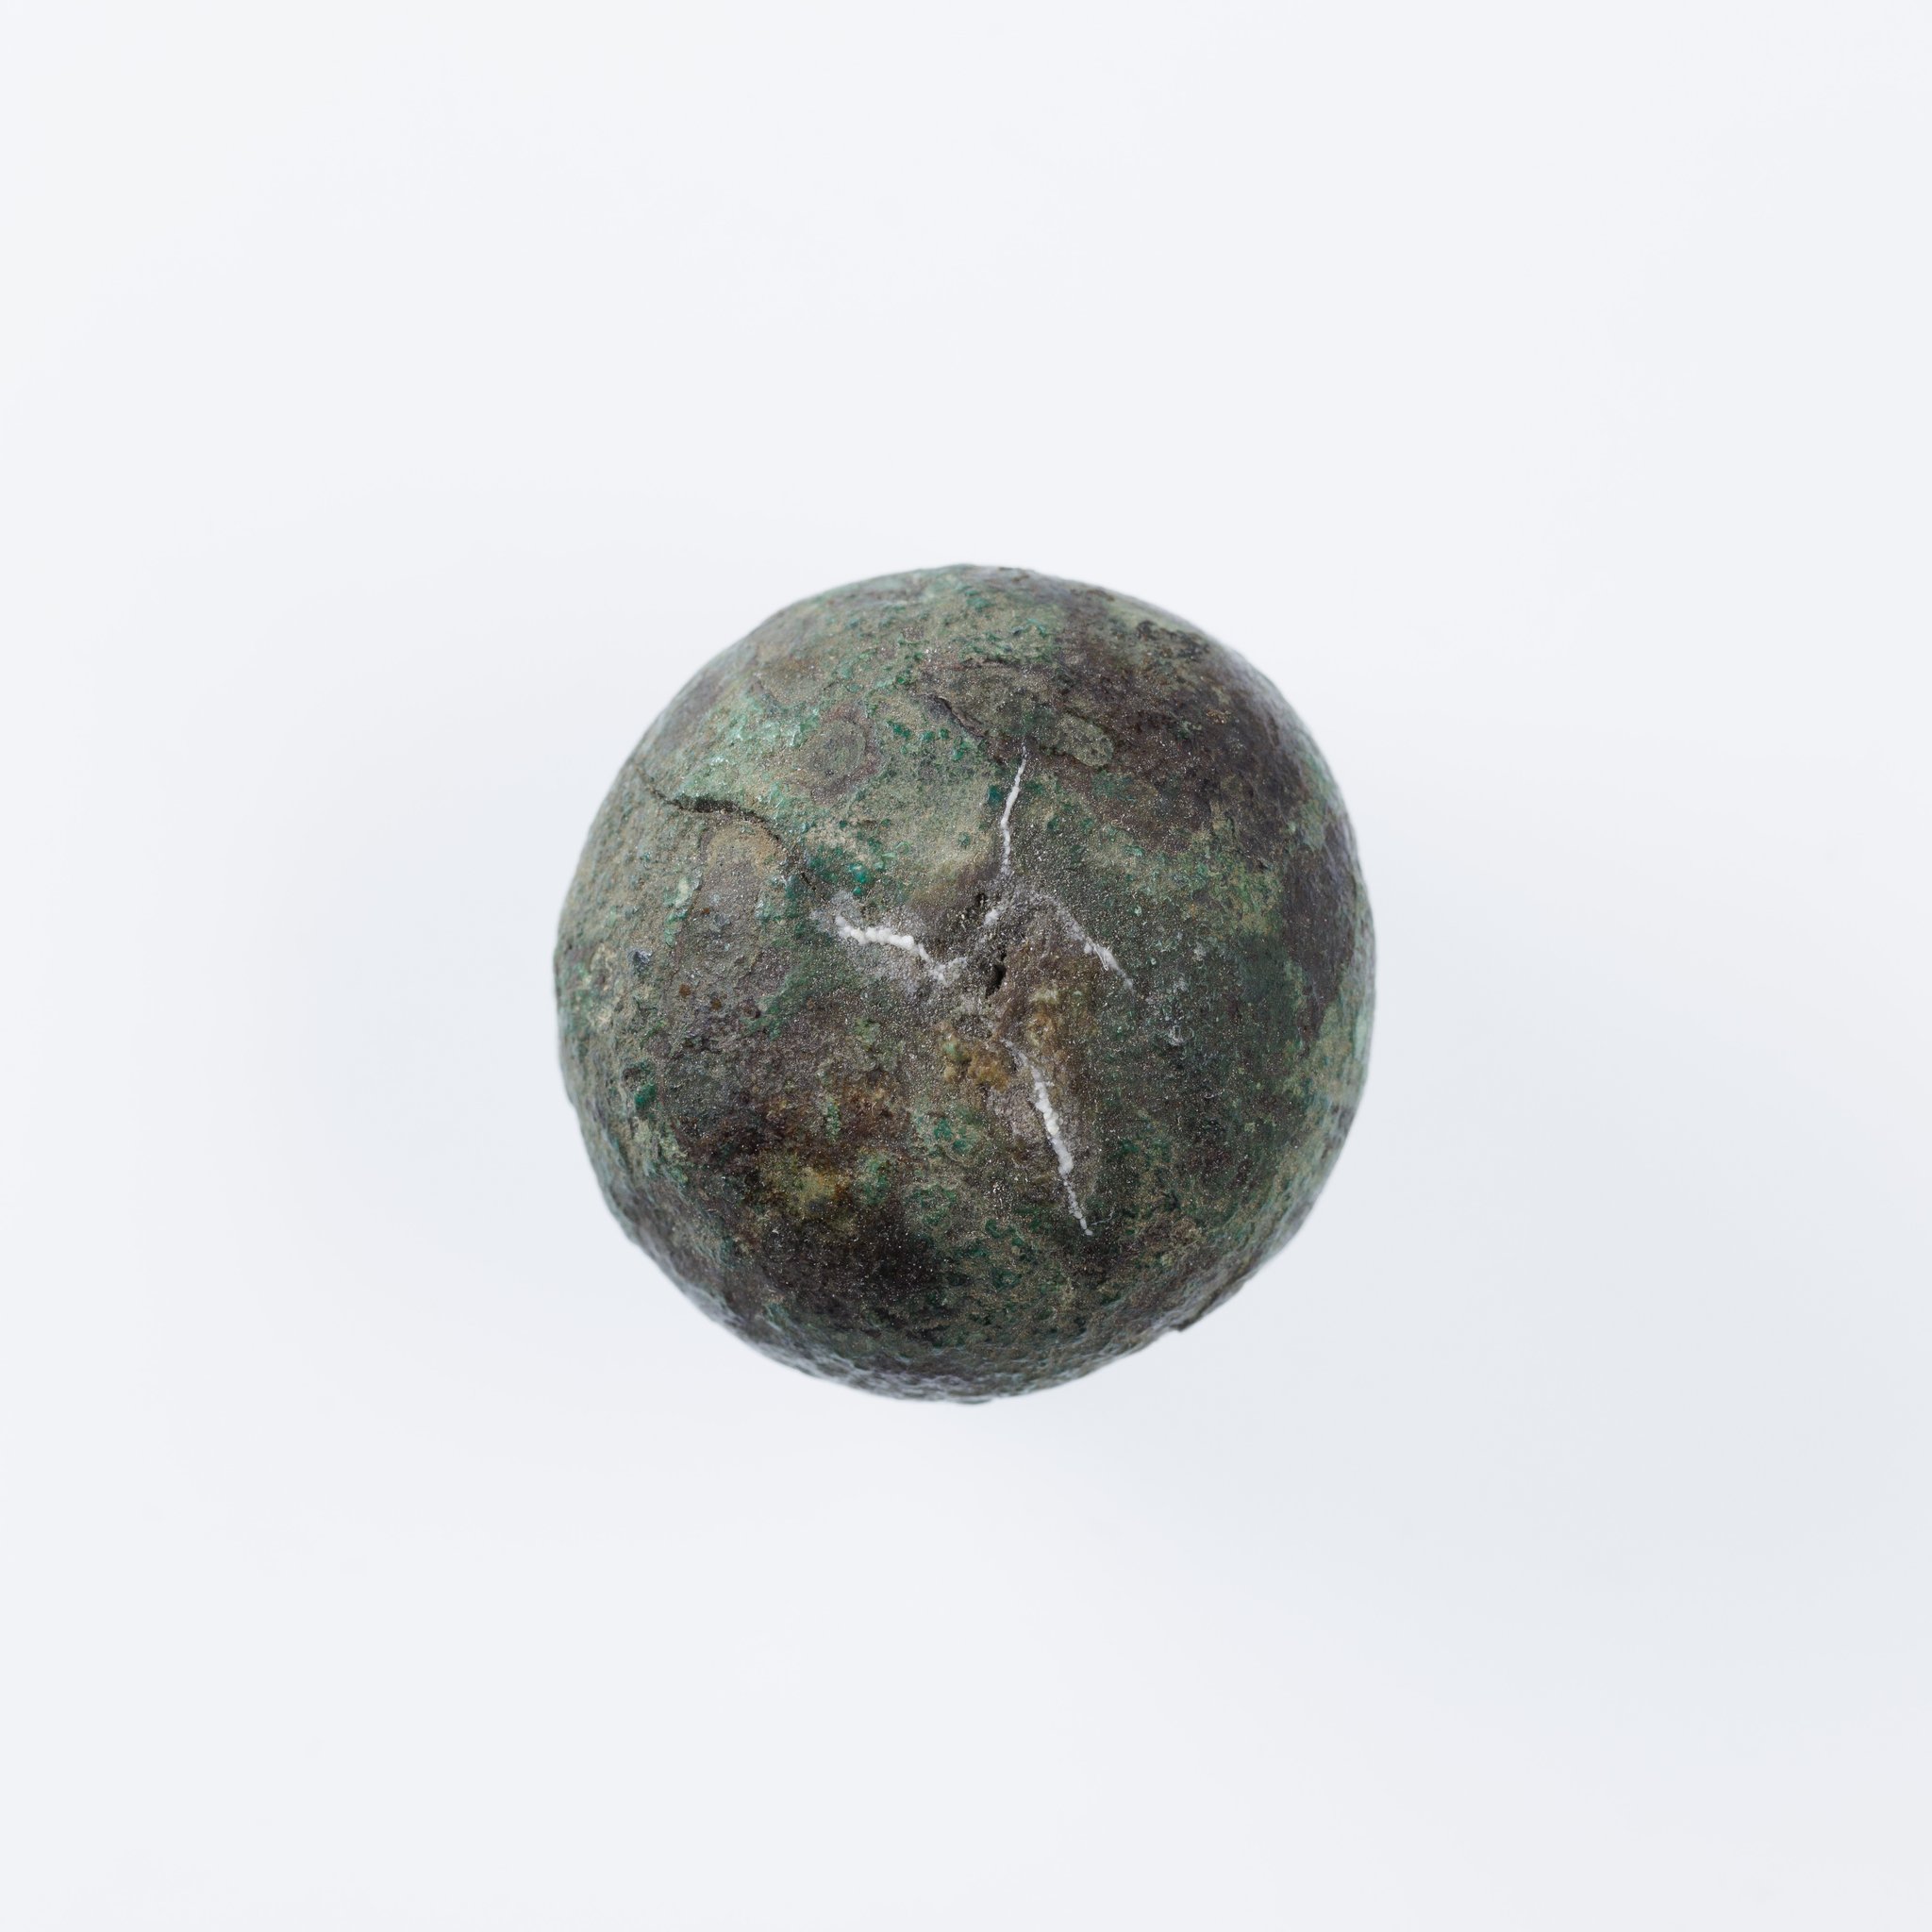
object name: weight, 5 kedets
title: Weight of 5 Kedets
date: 1550-1295 BCE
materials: bronze, copper alloy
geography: egypt